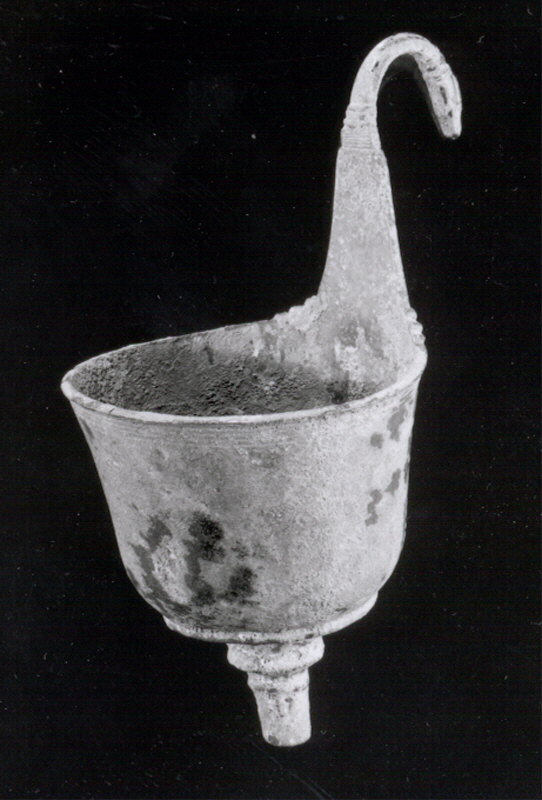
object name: strainer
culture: iranian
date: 800-601 BCE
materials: bronze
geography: iran